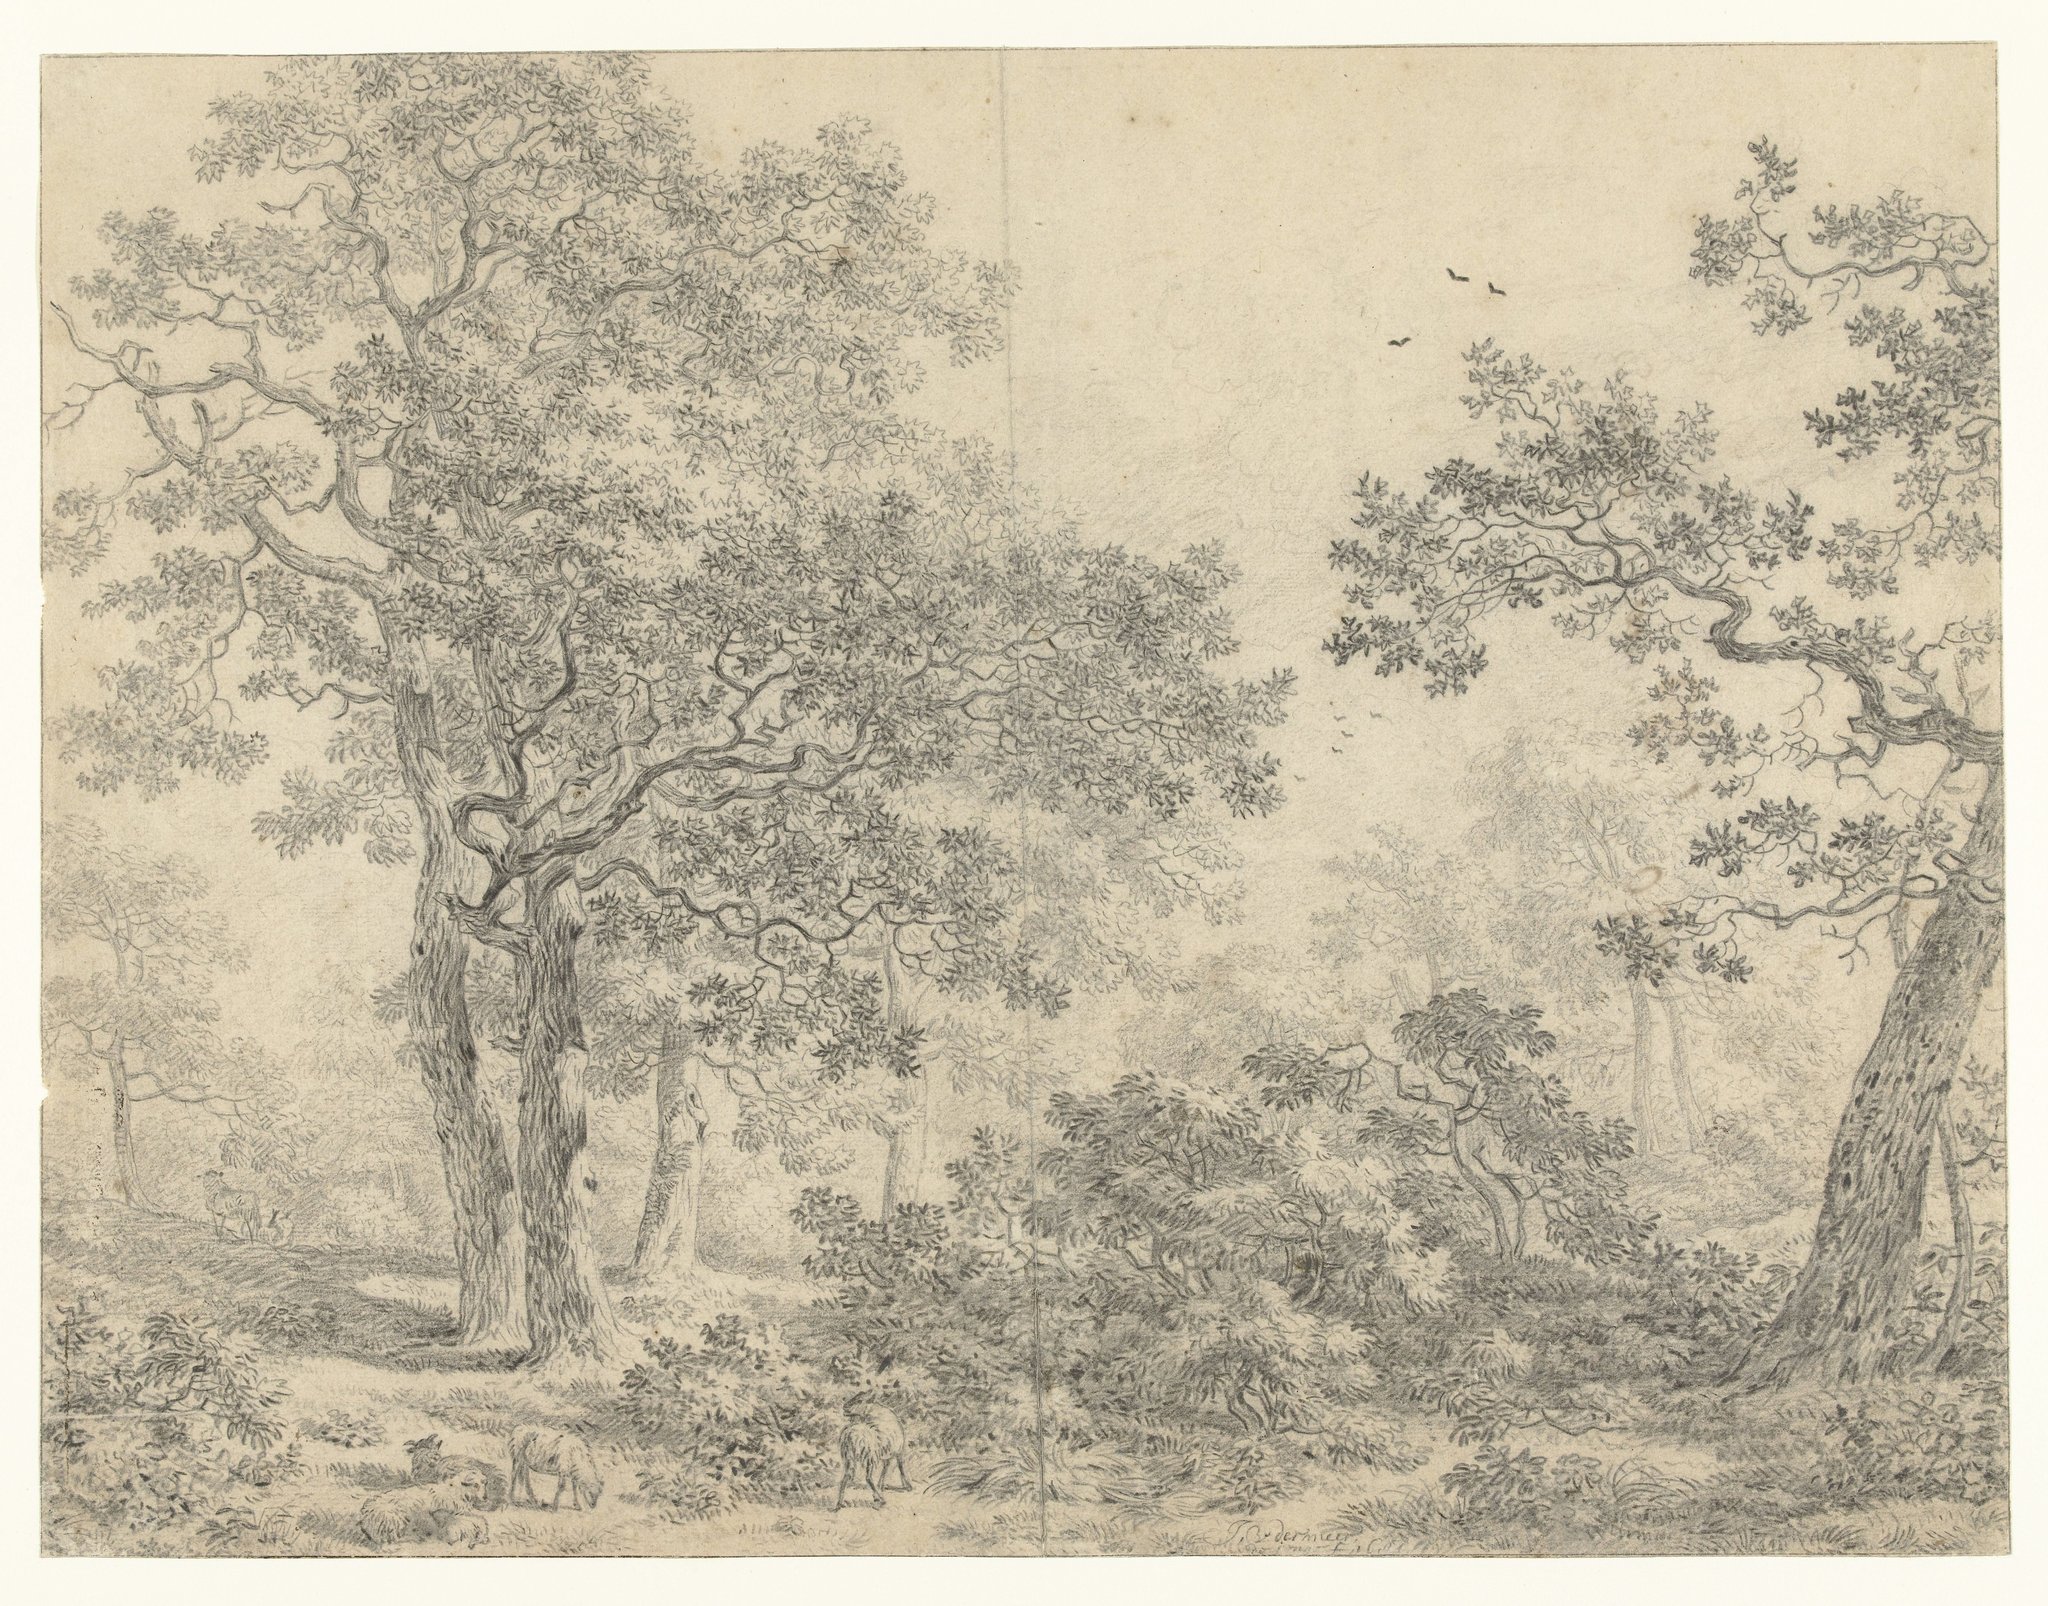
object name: drawing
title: Wooded Landscape with Sheep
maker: jan van der meer (ii)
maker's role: draughtsman, print maker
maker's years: 1656-1705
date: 1681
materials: chalk, paper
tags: forest, wood